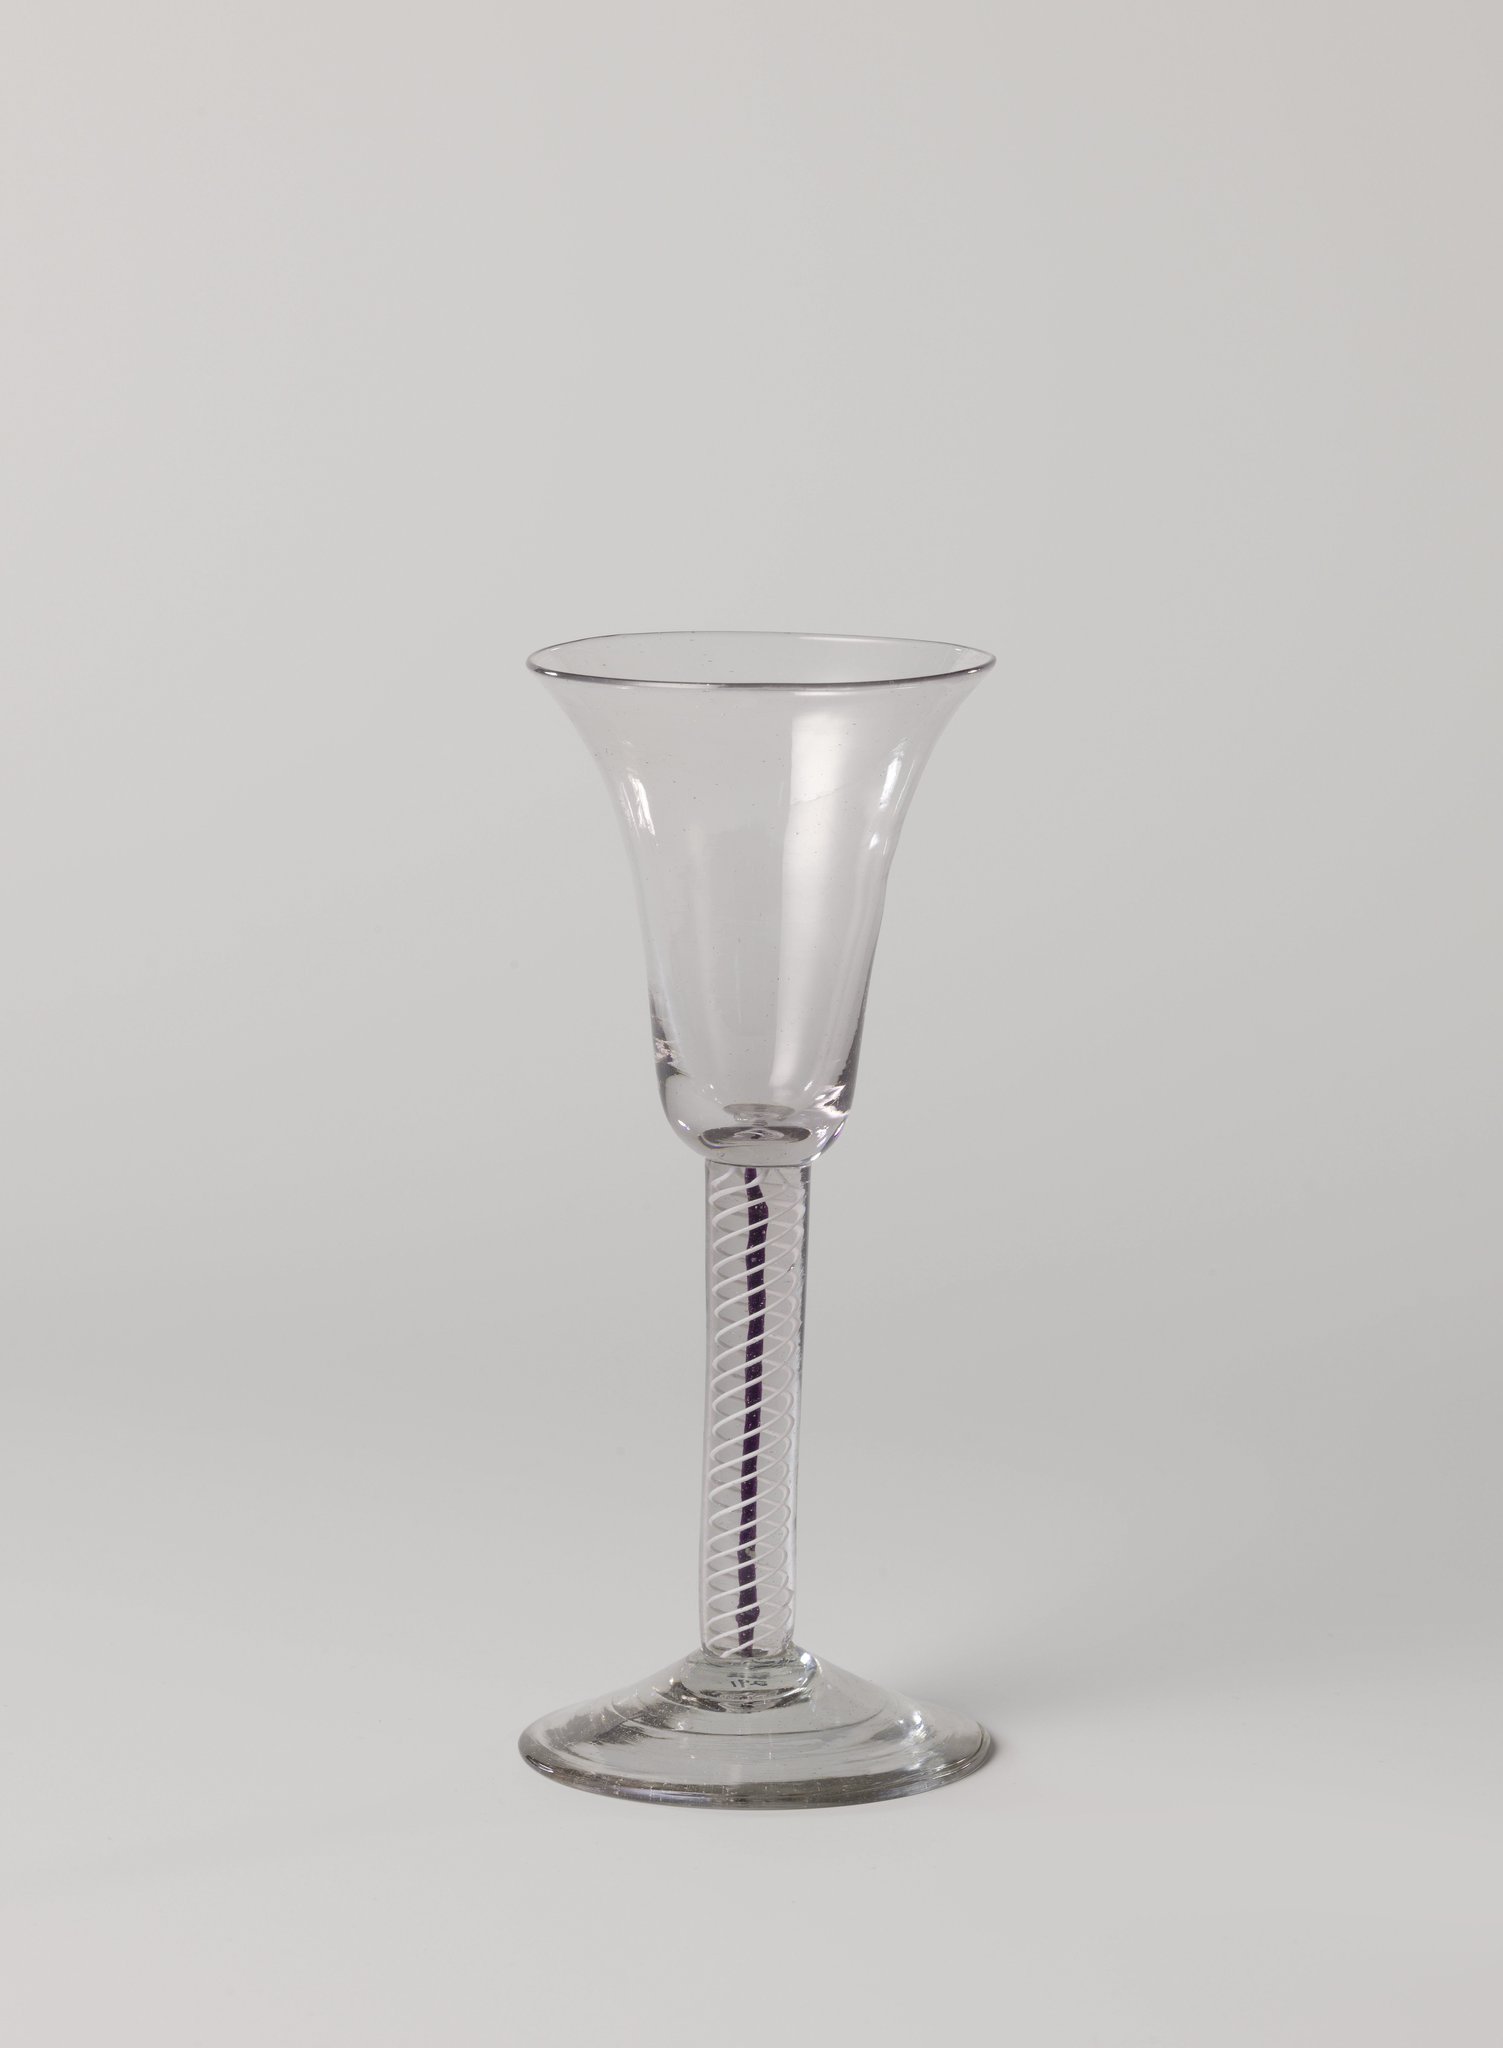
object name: goblet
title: Slingerglas met klokvormige kelk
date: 1750-1775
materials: glass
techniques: glassblowing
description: Slingerglas met conische voet en rechte stam. In de stam dubbele witte spiraal rond een blauwe staaf. Klokvormige kelk.